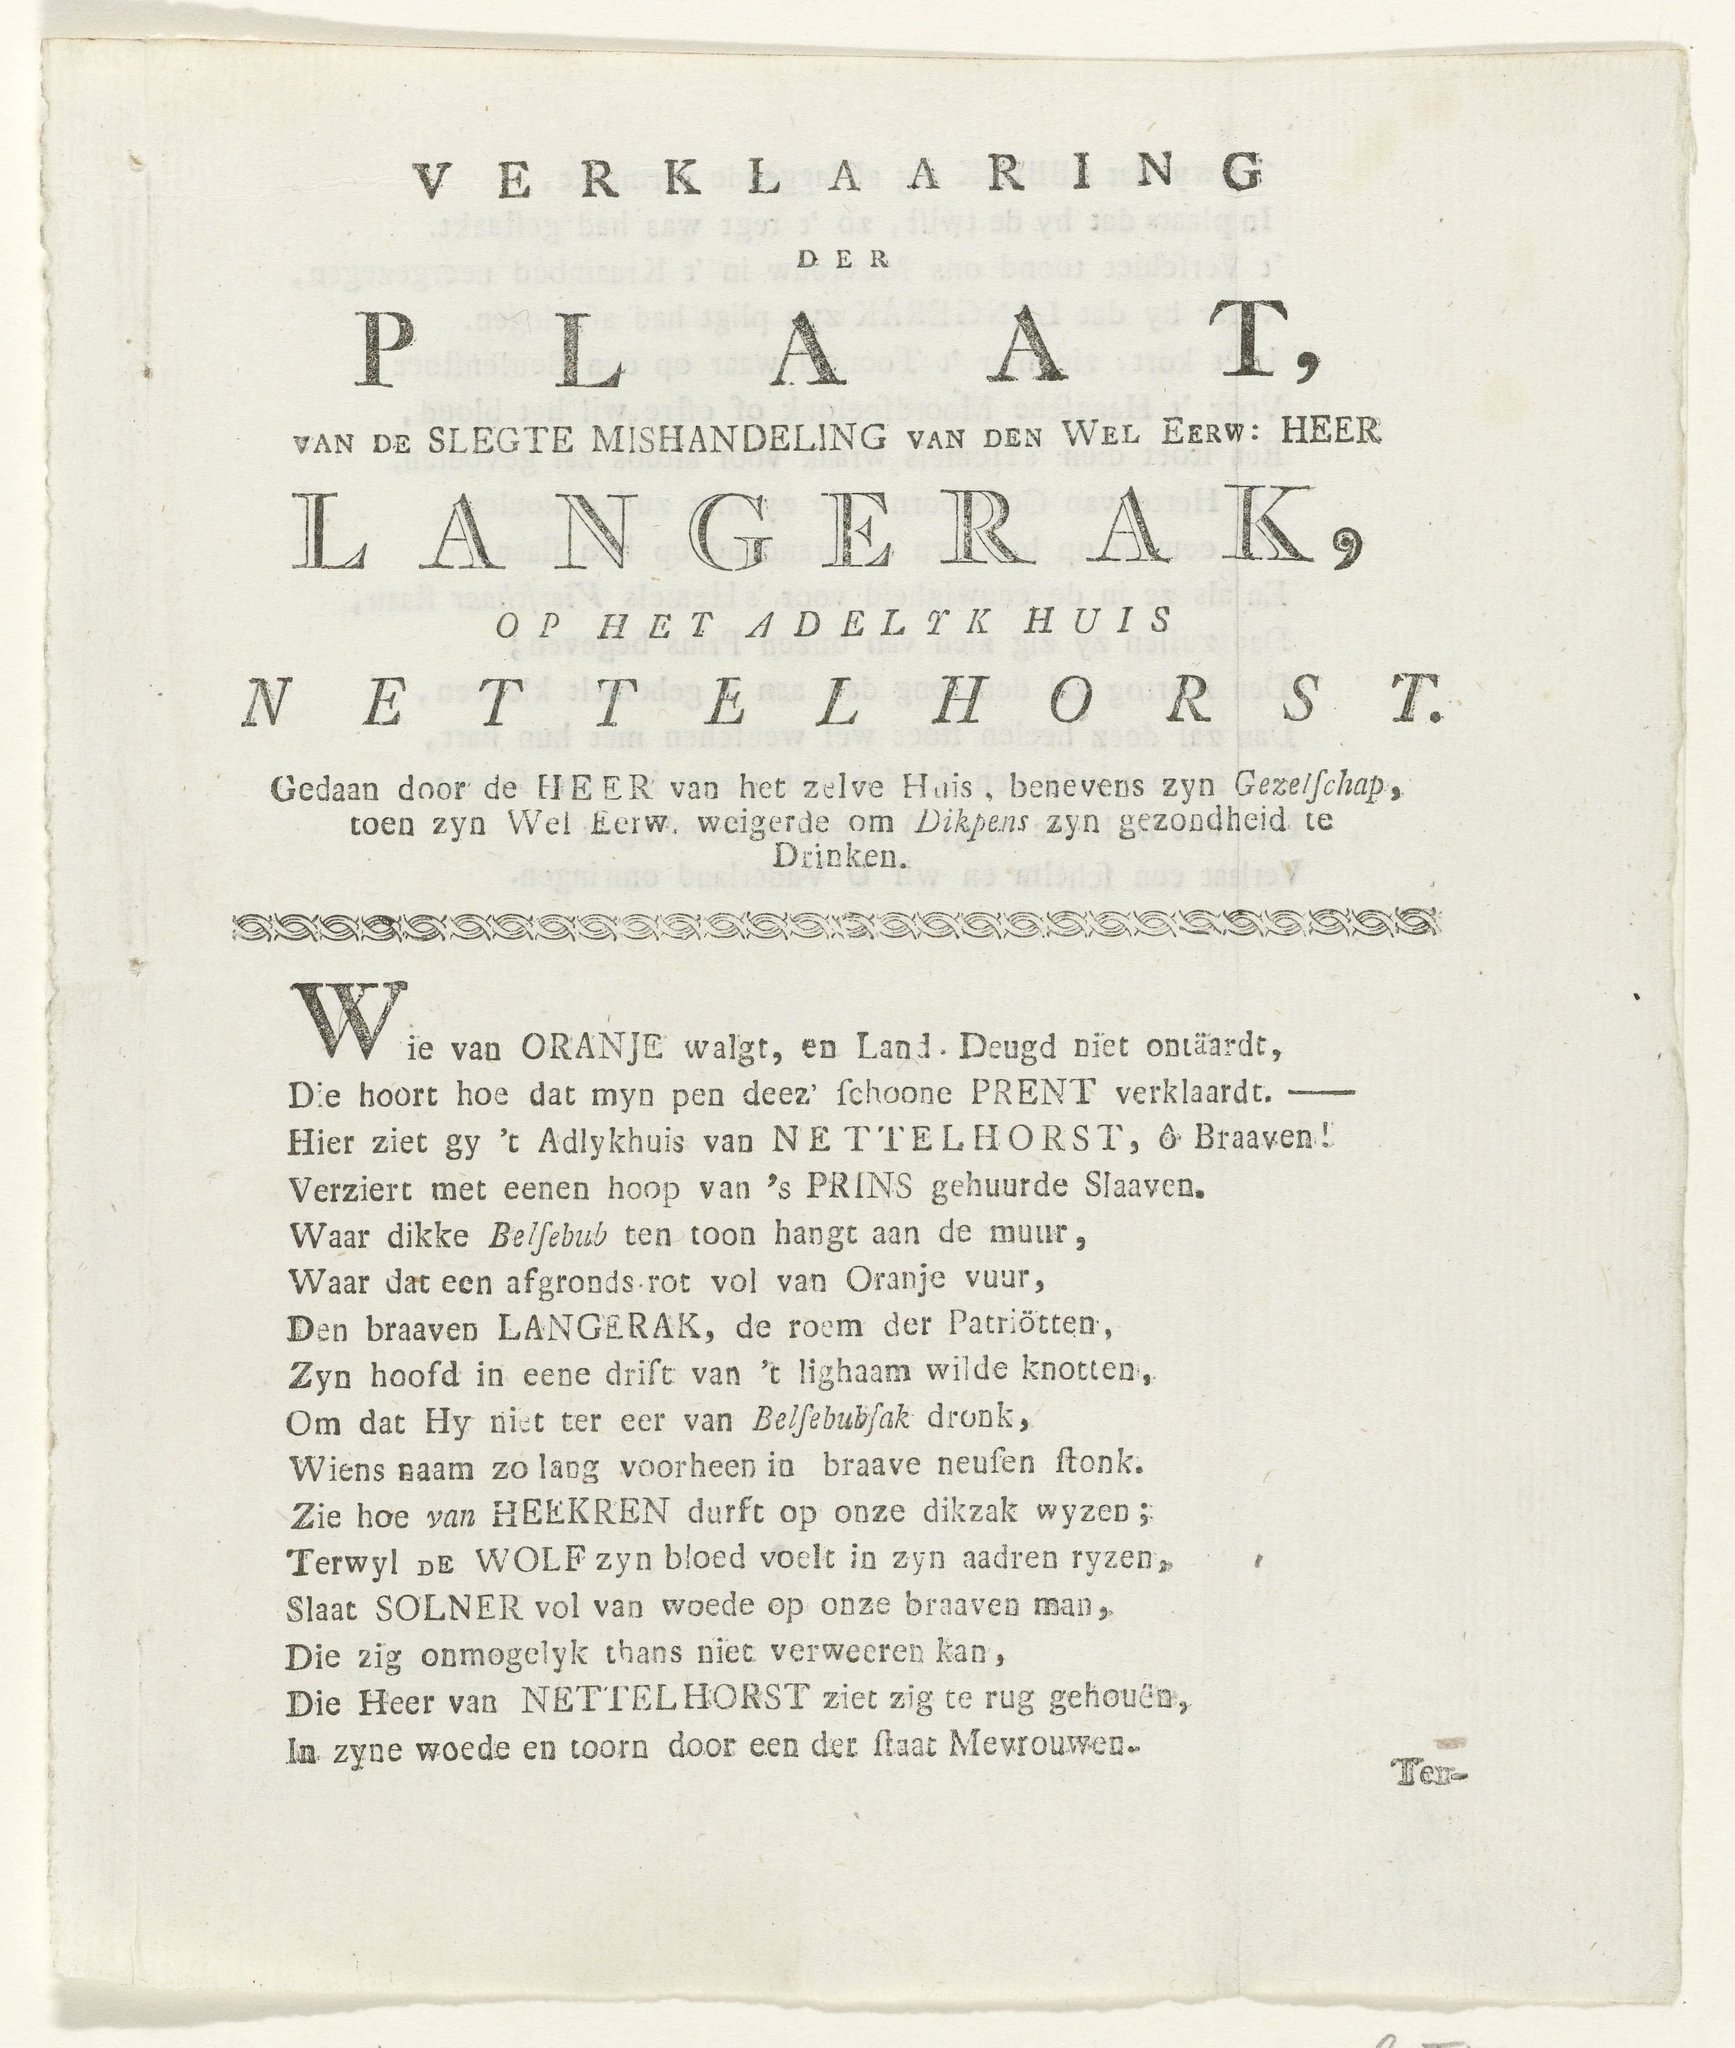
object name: text sheet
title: Verklaring van de prent van de mishandeling van de predikant Langerak, 1784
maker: d. de vries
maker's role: publisher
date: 1784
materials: paper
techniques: letterpress printing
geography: delfshaven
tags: ludwig ernst von braunschweig-wolfenbüttel, patriots (1780-1795)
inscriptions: collector's mark: Lugt 2228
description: Tekstblad met een verklaring in dichtvorm van de prent van de mishandeling van de predikant Langerak uit Laren op het Huis Nettelhorst bij Lochem door baron van Heeckeren, burgemeester De Wolff van Lochem en de heer Sölner omdat de predikant weigerde te drinken op de gezondheid van de hertog van Brunswijk, juli 1784. Blad bedrukt op beide zijden, genomen uit een gebonden uitgave.